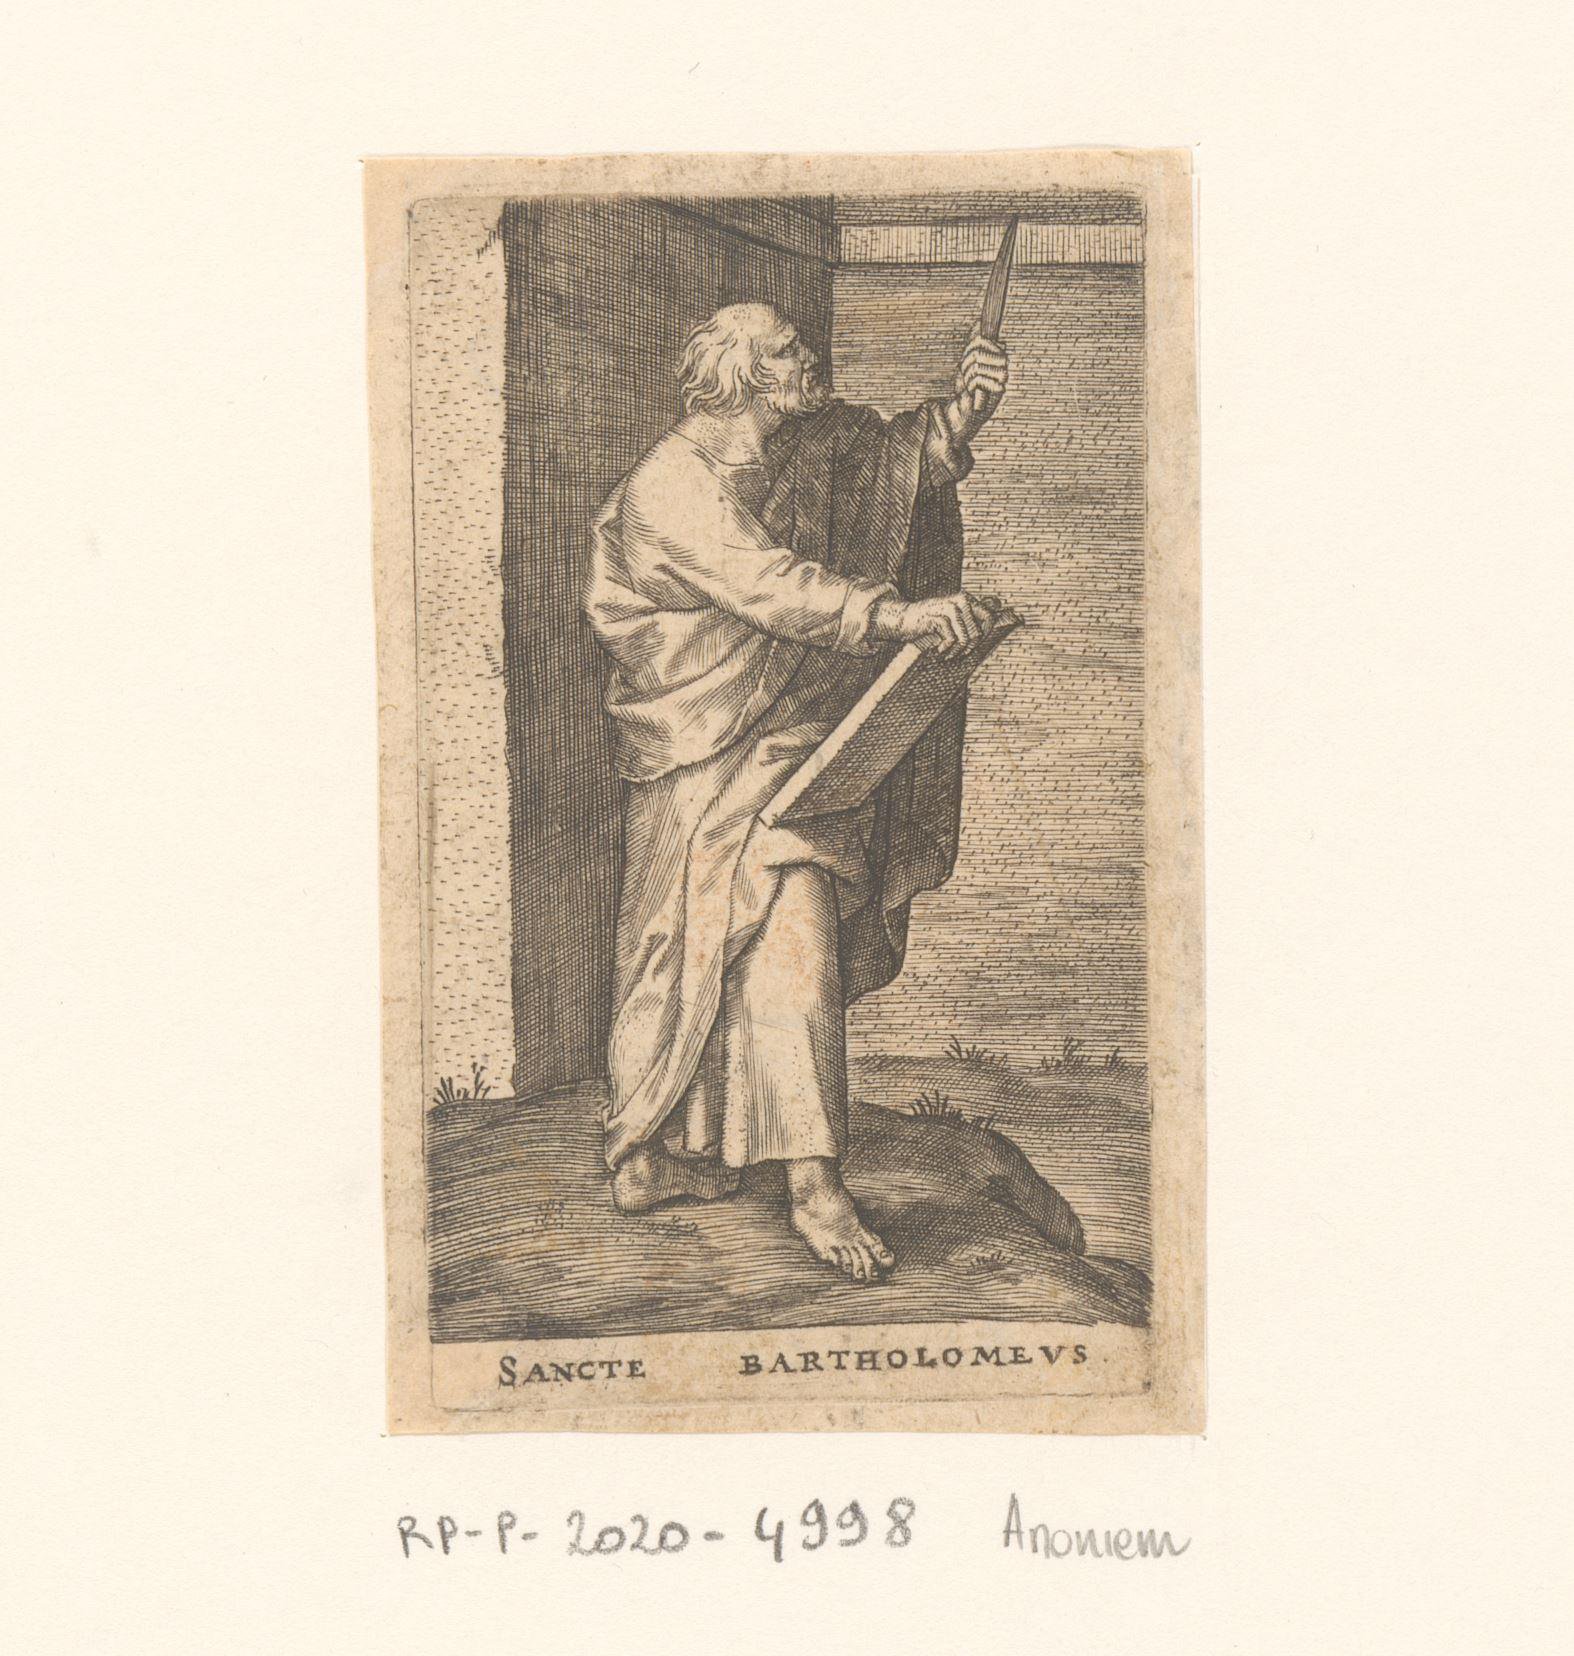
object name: print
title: Apostel Bartholomeus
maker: Anonymous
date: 1550-1600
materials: paper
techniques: engraving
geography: southern netherlands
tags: the apostle bartholomew; possible attributes: book, devil or dragon at feet, knife, scroll, flayed skin, staff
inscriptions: collector's mark: Lugt 2228